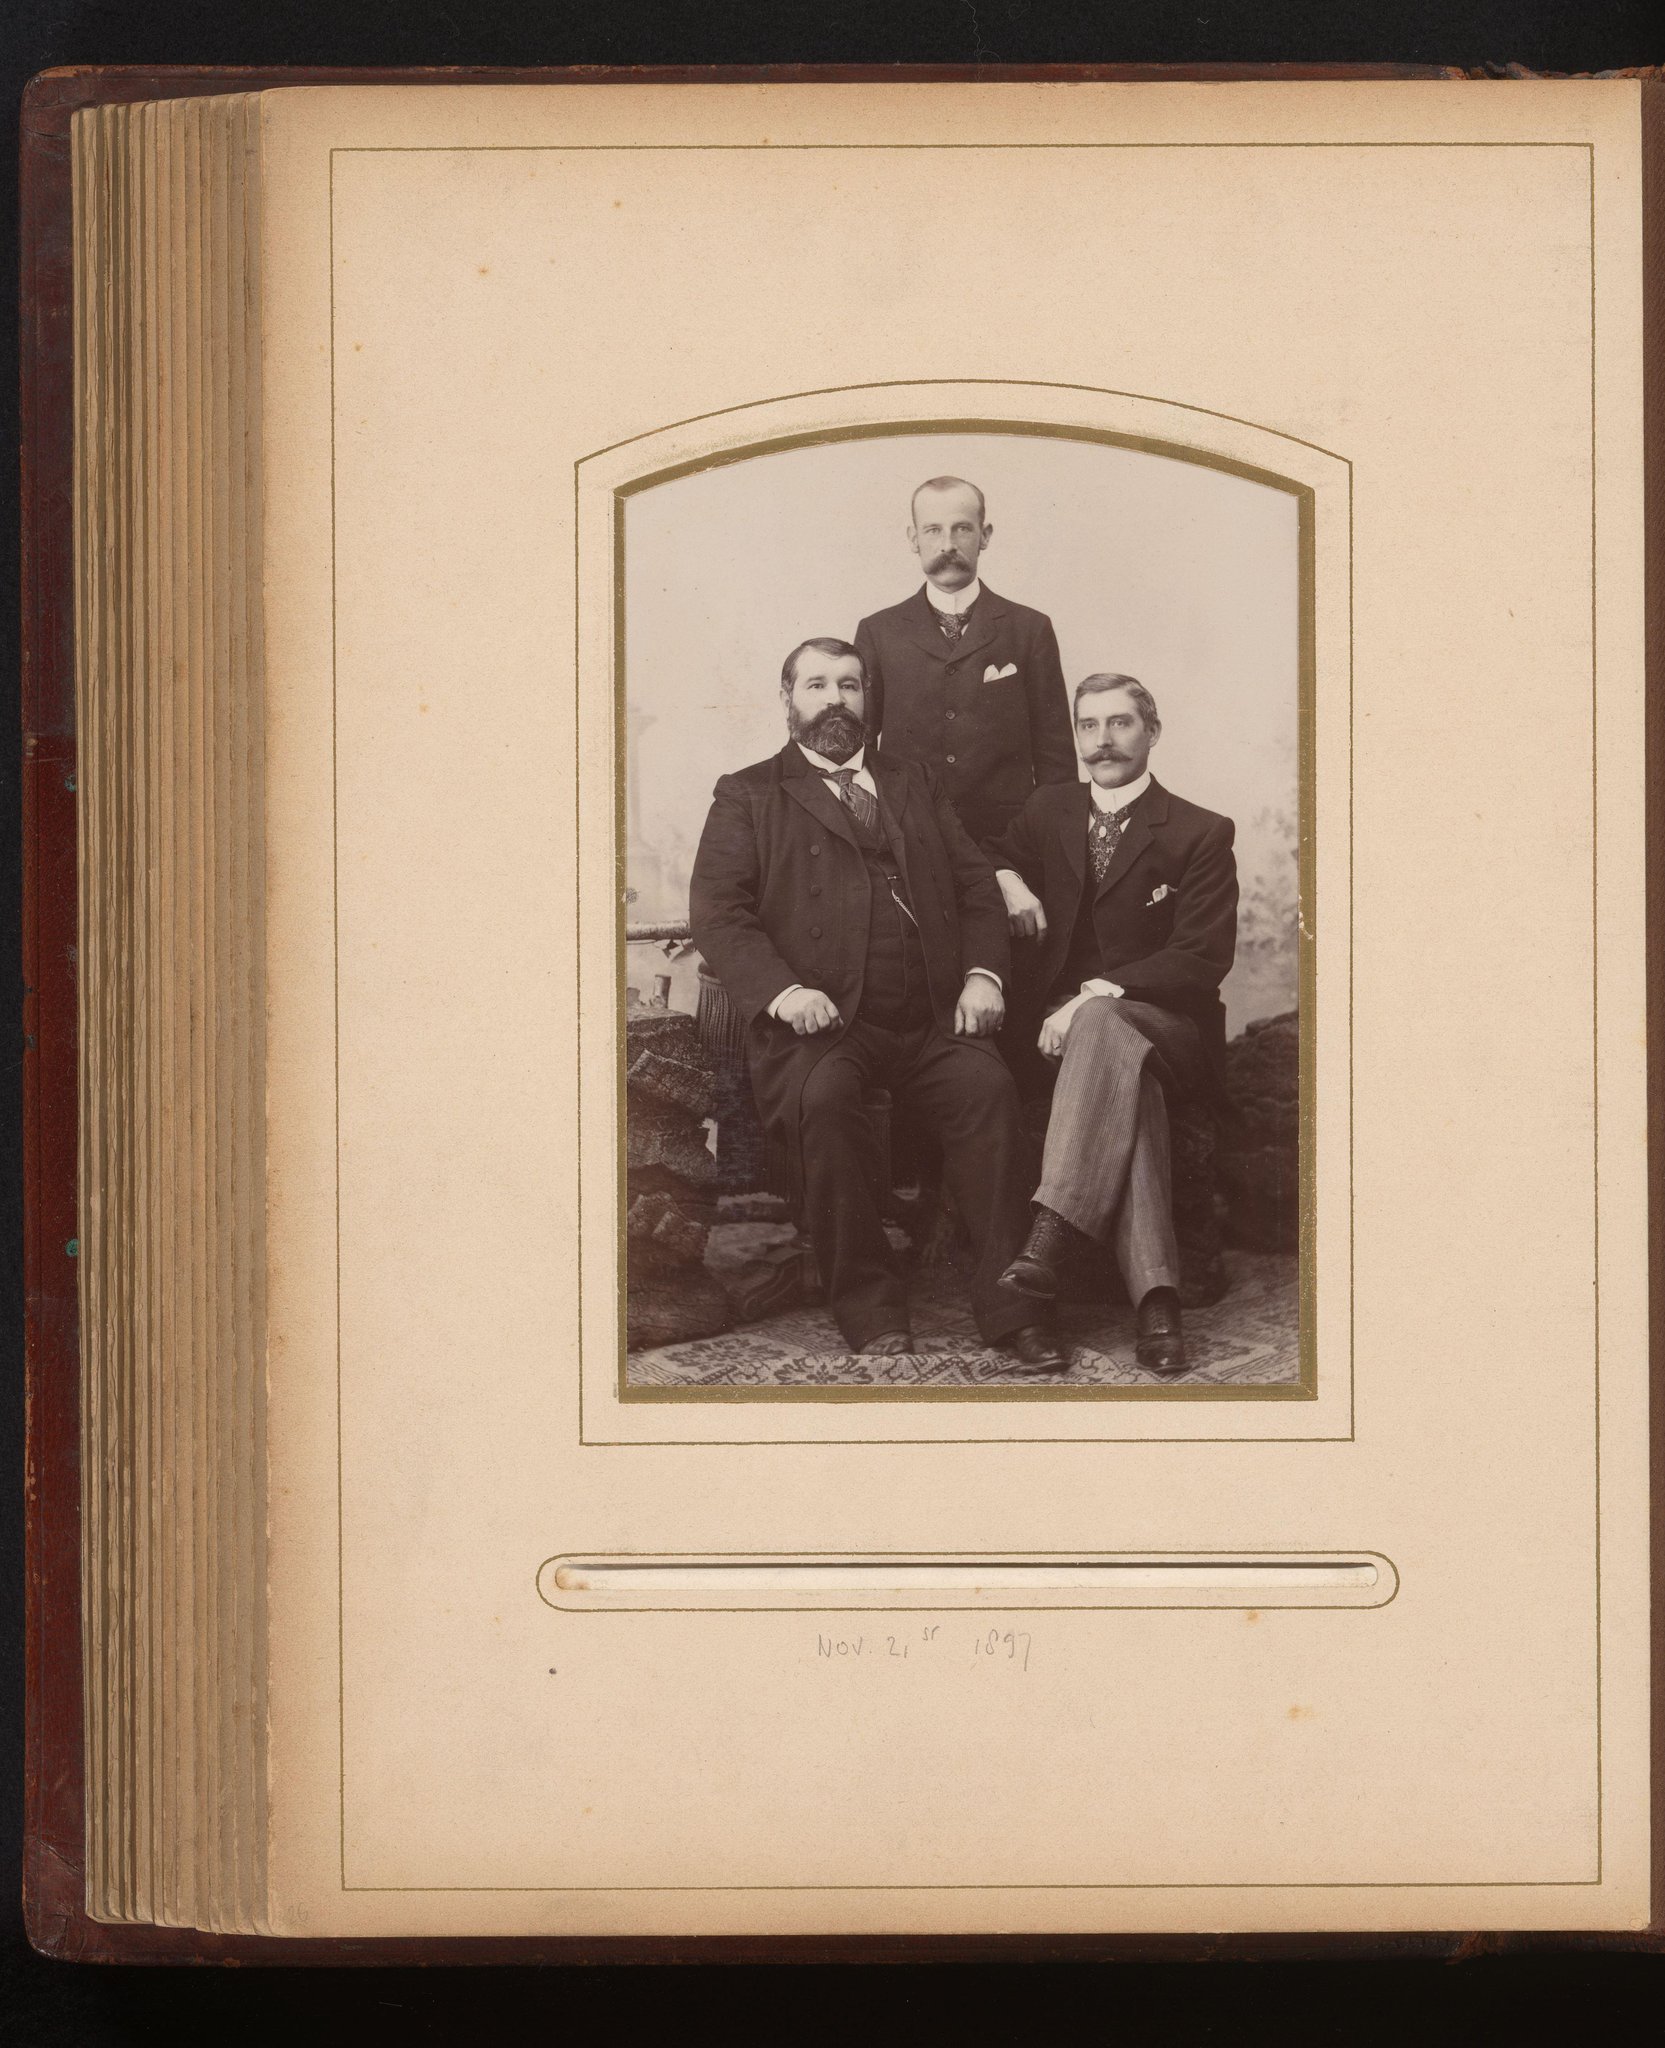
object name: album leaf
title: Portret van drie mannen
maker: e. schlenker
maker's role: fotograaf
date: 1897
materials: cardboard, photographic support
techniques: albumen print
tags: moustache, adult man, historical persons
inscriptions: annotation: ‘Now, 21st, 1897’, inscription: ‘E. Schlenker Wädenswell’